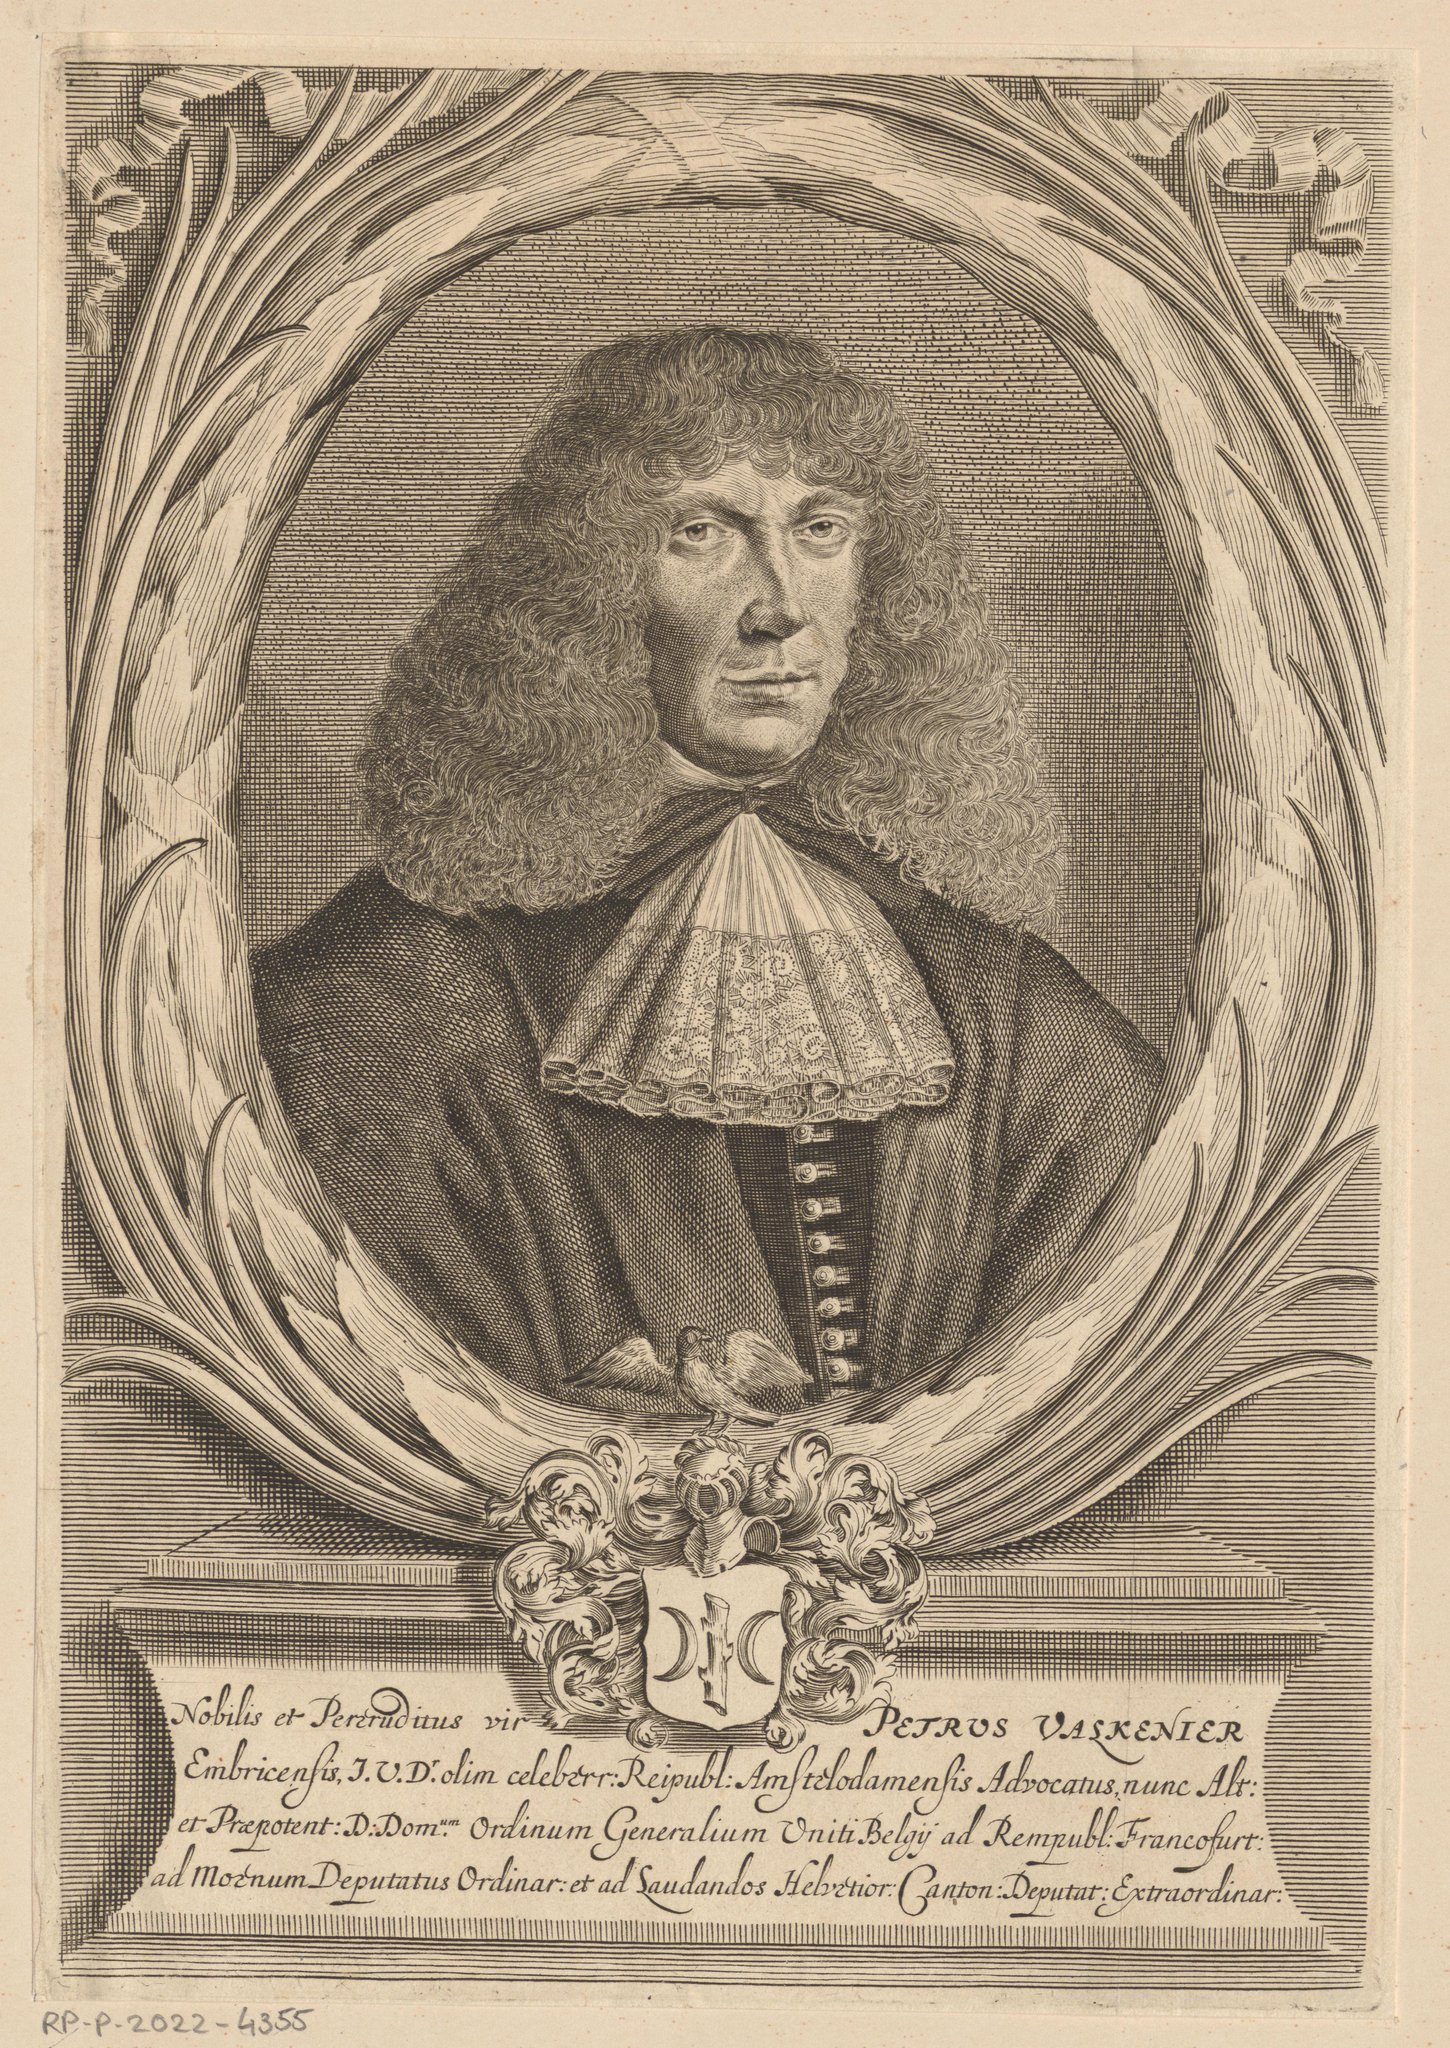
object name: print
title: Portret van Pieter Valckenier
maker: Anonymous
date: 1690-1750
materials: paper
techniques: engraving, etching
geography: northern netherlands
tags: historical persons, lawyer, attorney at law, diplomacy, diplomat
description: Met een vierregelig onderschrift in het Latijn.